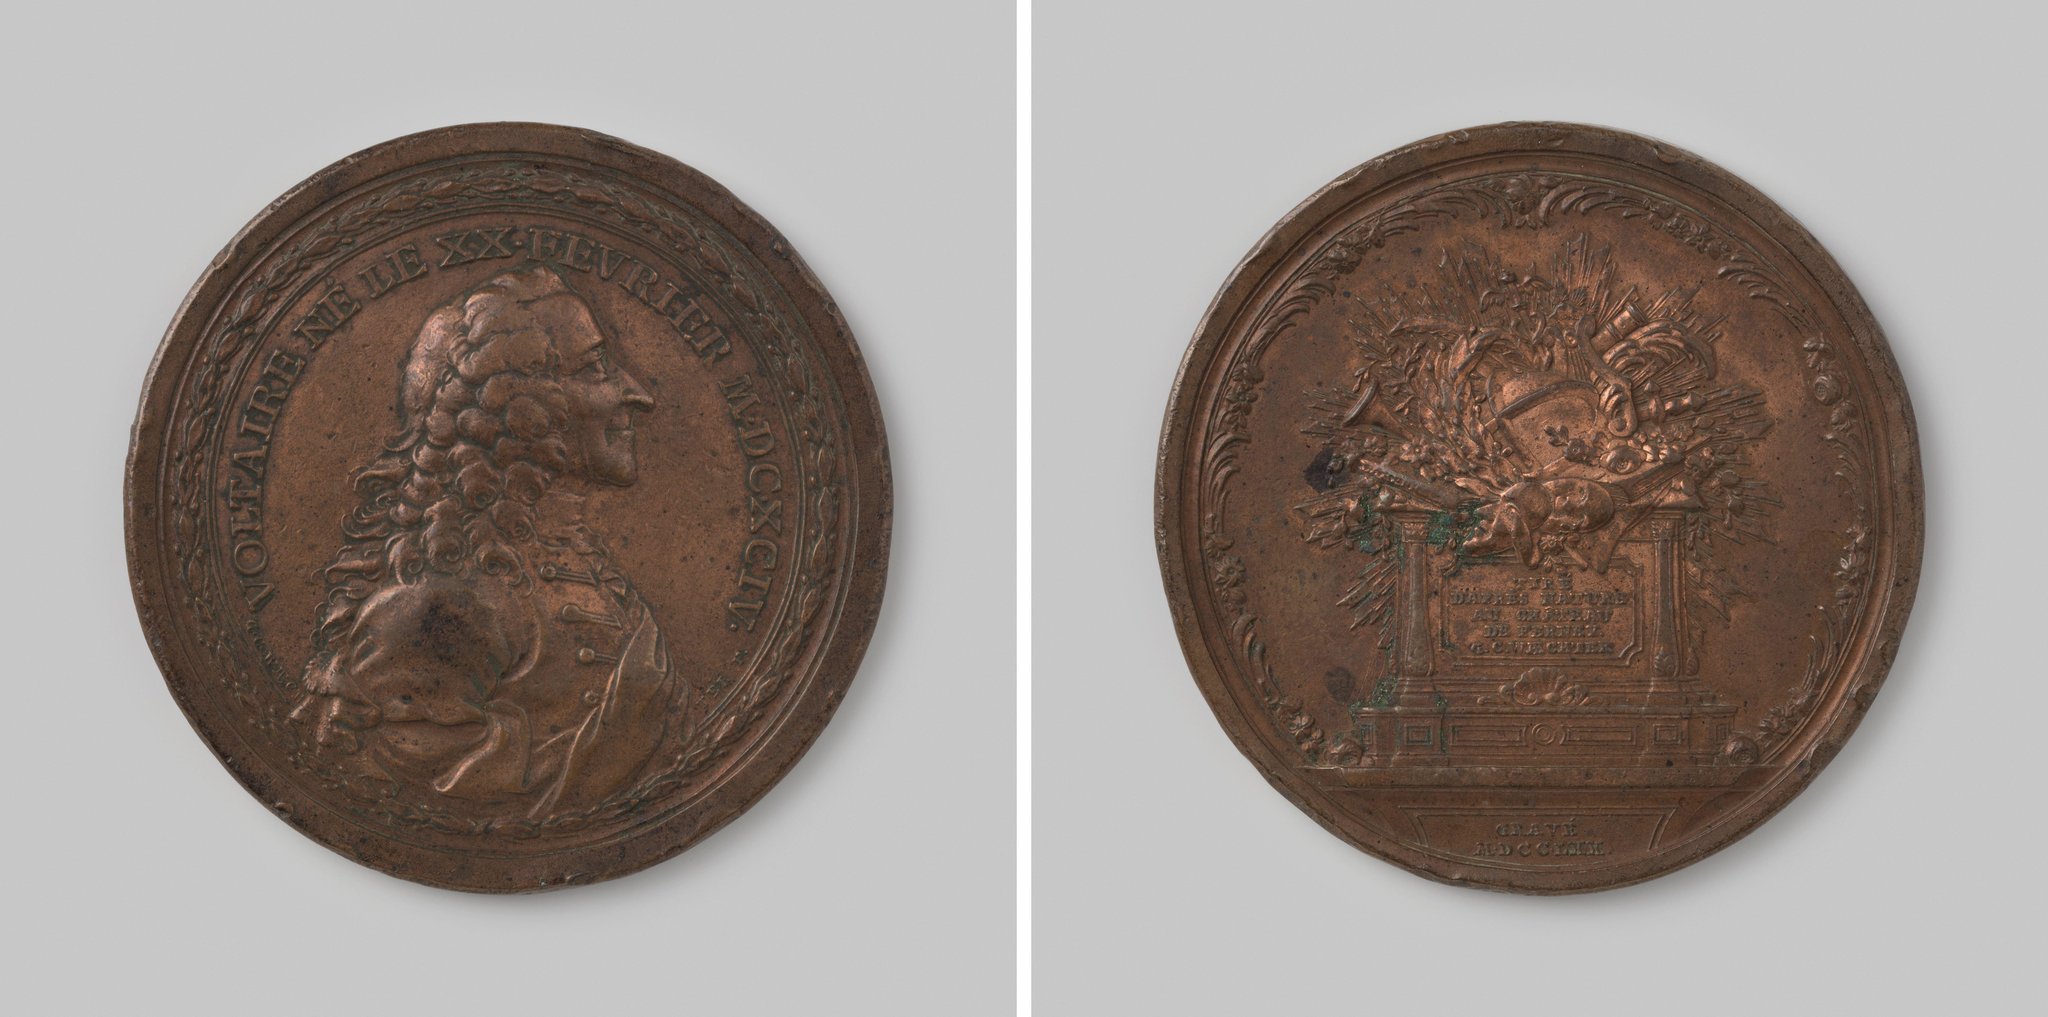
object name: history medal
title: Voltaire (1770)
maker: georg christian waechter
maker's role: die cutter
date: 1770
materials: copper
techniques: striking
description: Koperen penning, op de voorzijde het borstbeeld van Voltaire naar rechts met omschrift binnen een lauwerkrans, op de keerzijde een altaar waarop een trofee van symbolen van krijgskunst, handel, kunsten en wetenschappen op een stralende zon, binnen een ornamentale rand.